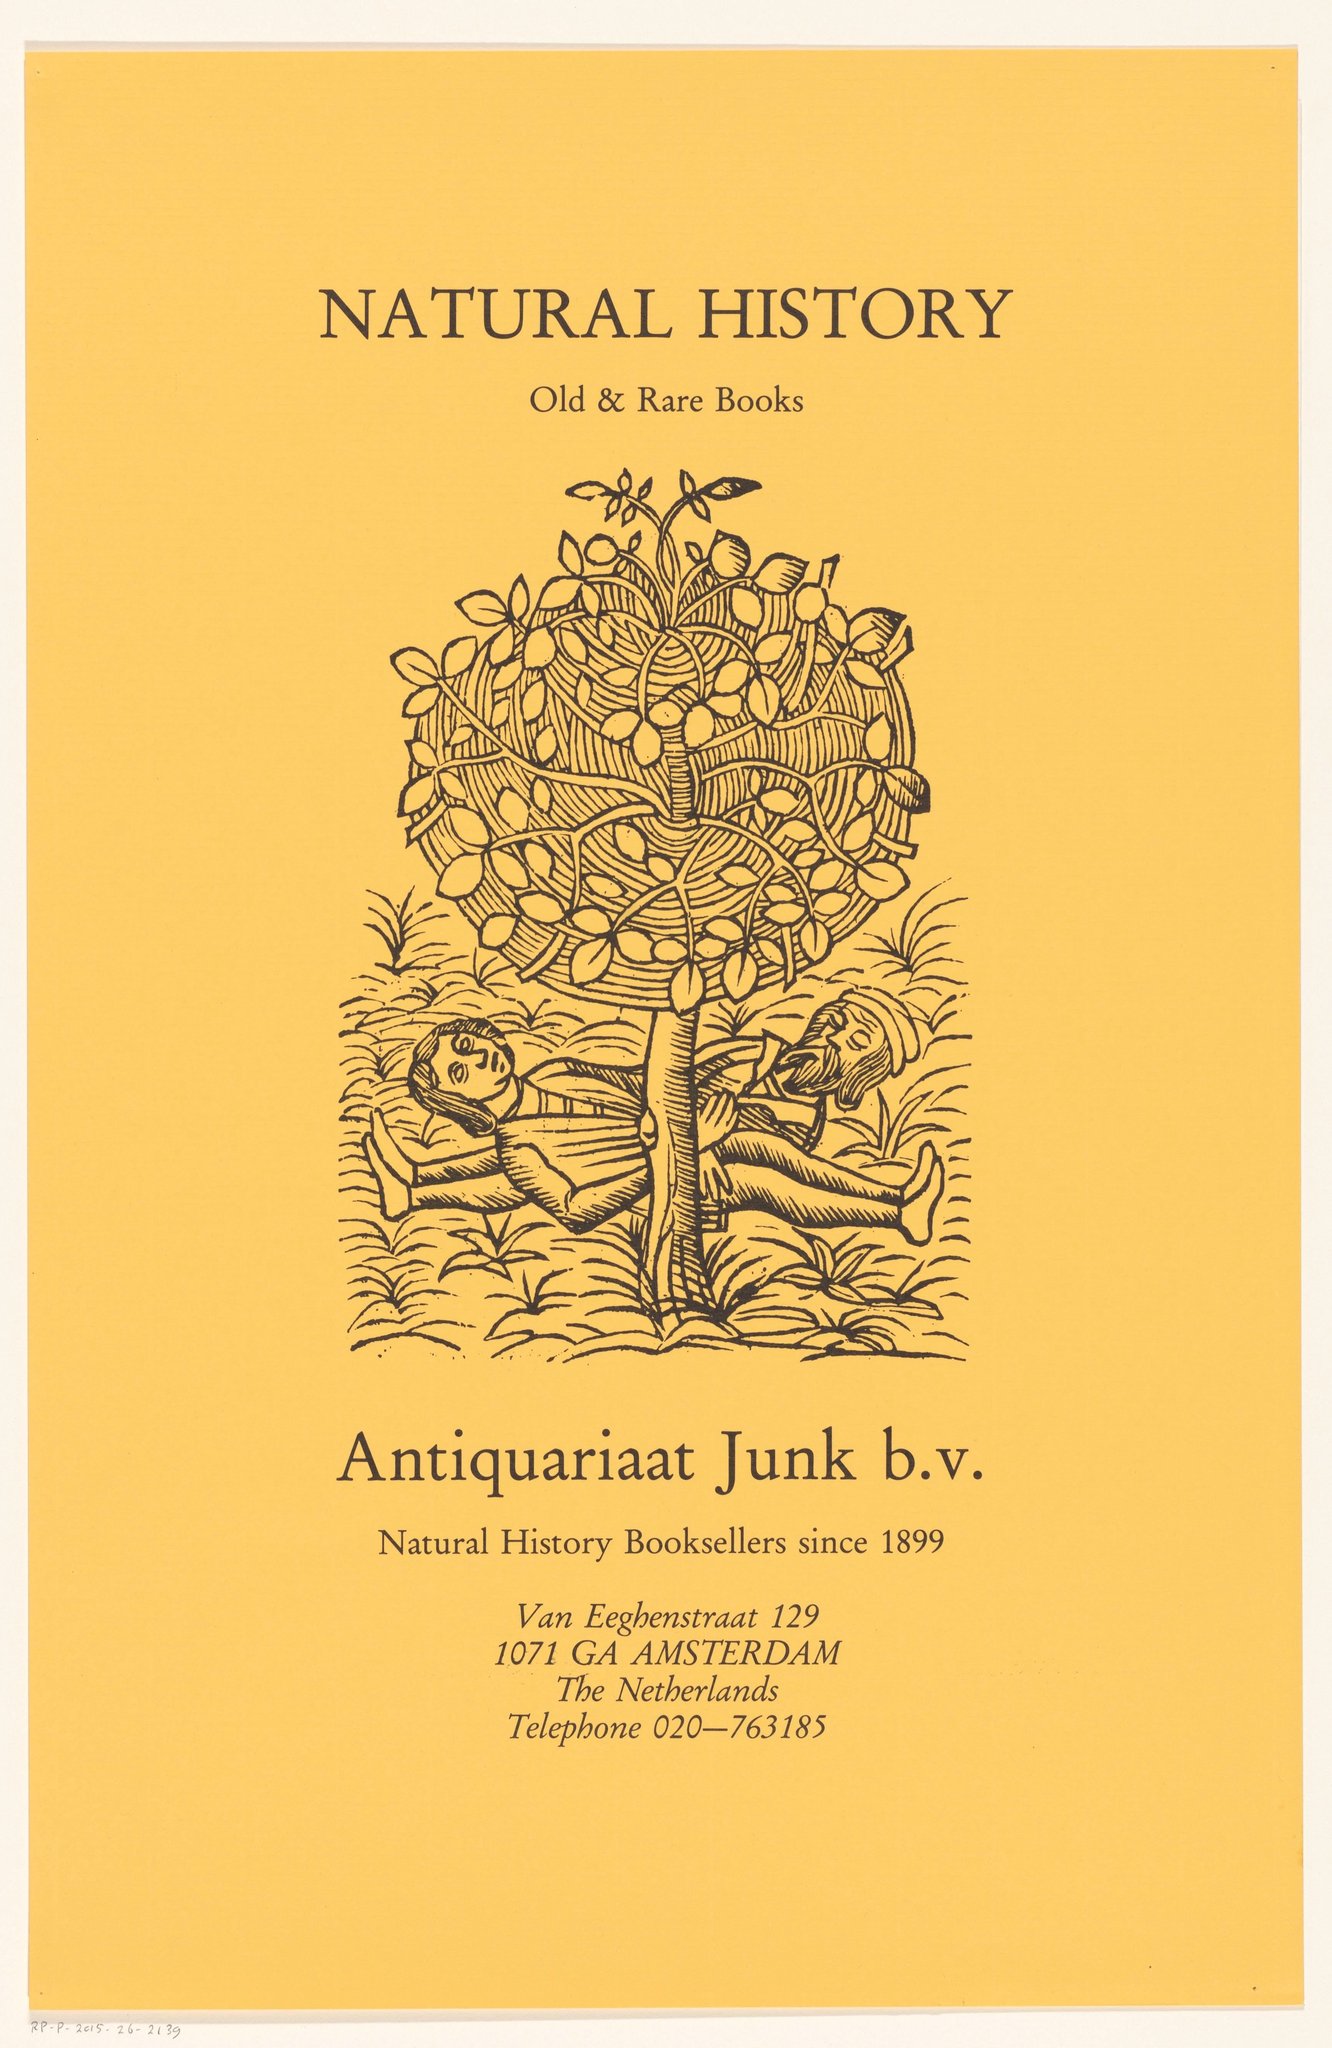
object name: poster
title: Affiche van Antiquariaat Junk te Amsterdam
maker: Anonymous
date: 1950-2000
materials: paper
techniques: mechanical printing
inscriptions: collector's mark: Lugt 2228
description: Affiche met twee slapende mannen onder een boom, waarschijnlijk ontleend aan een boekillustratie.